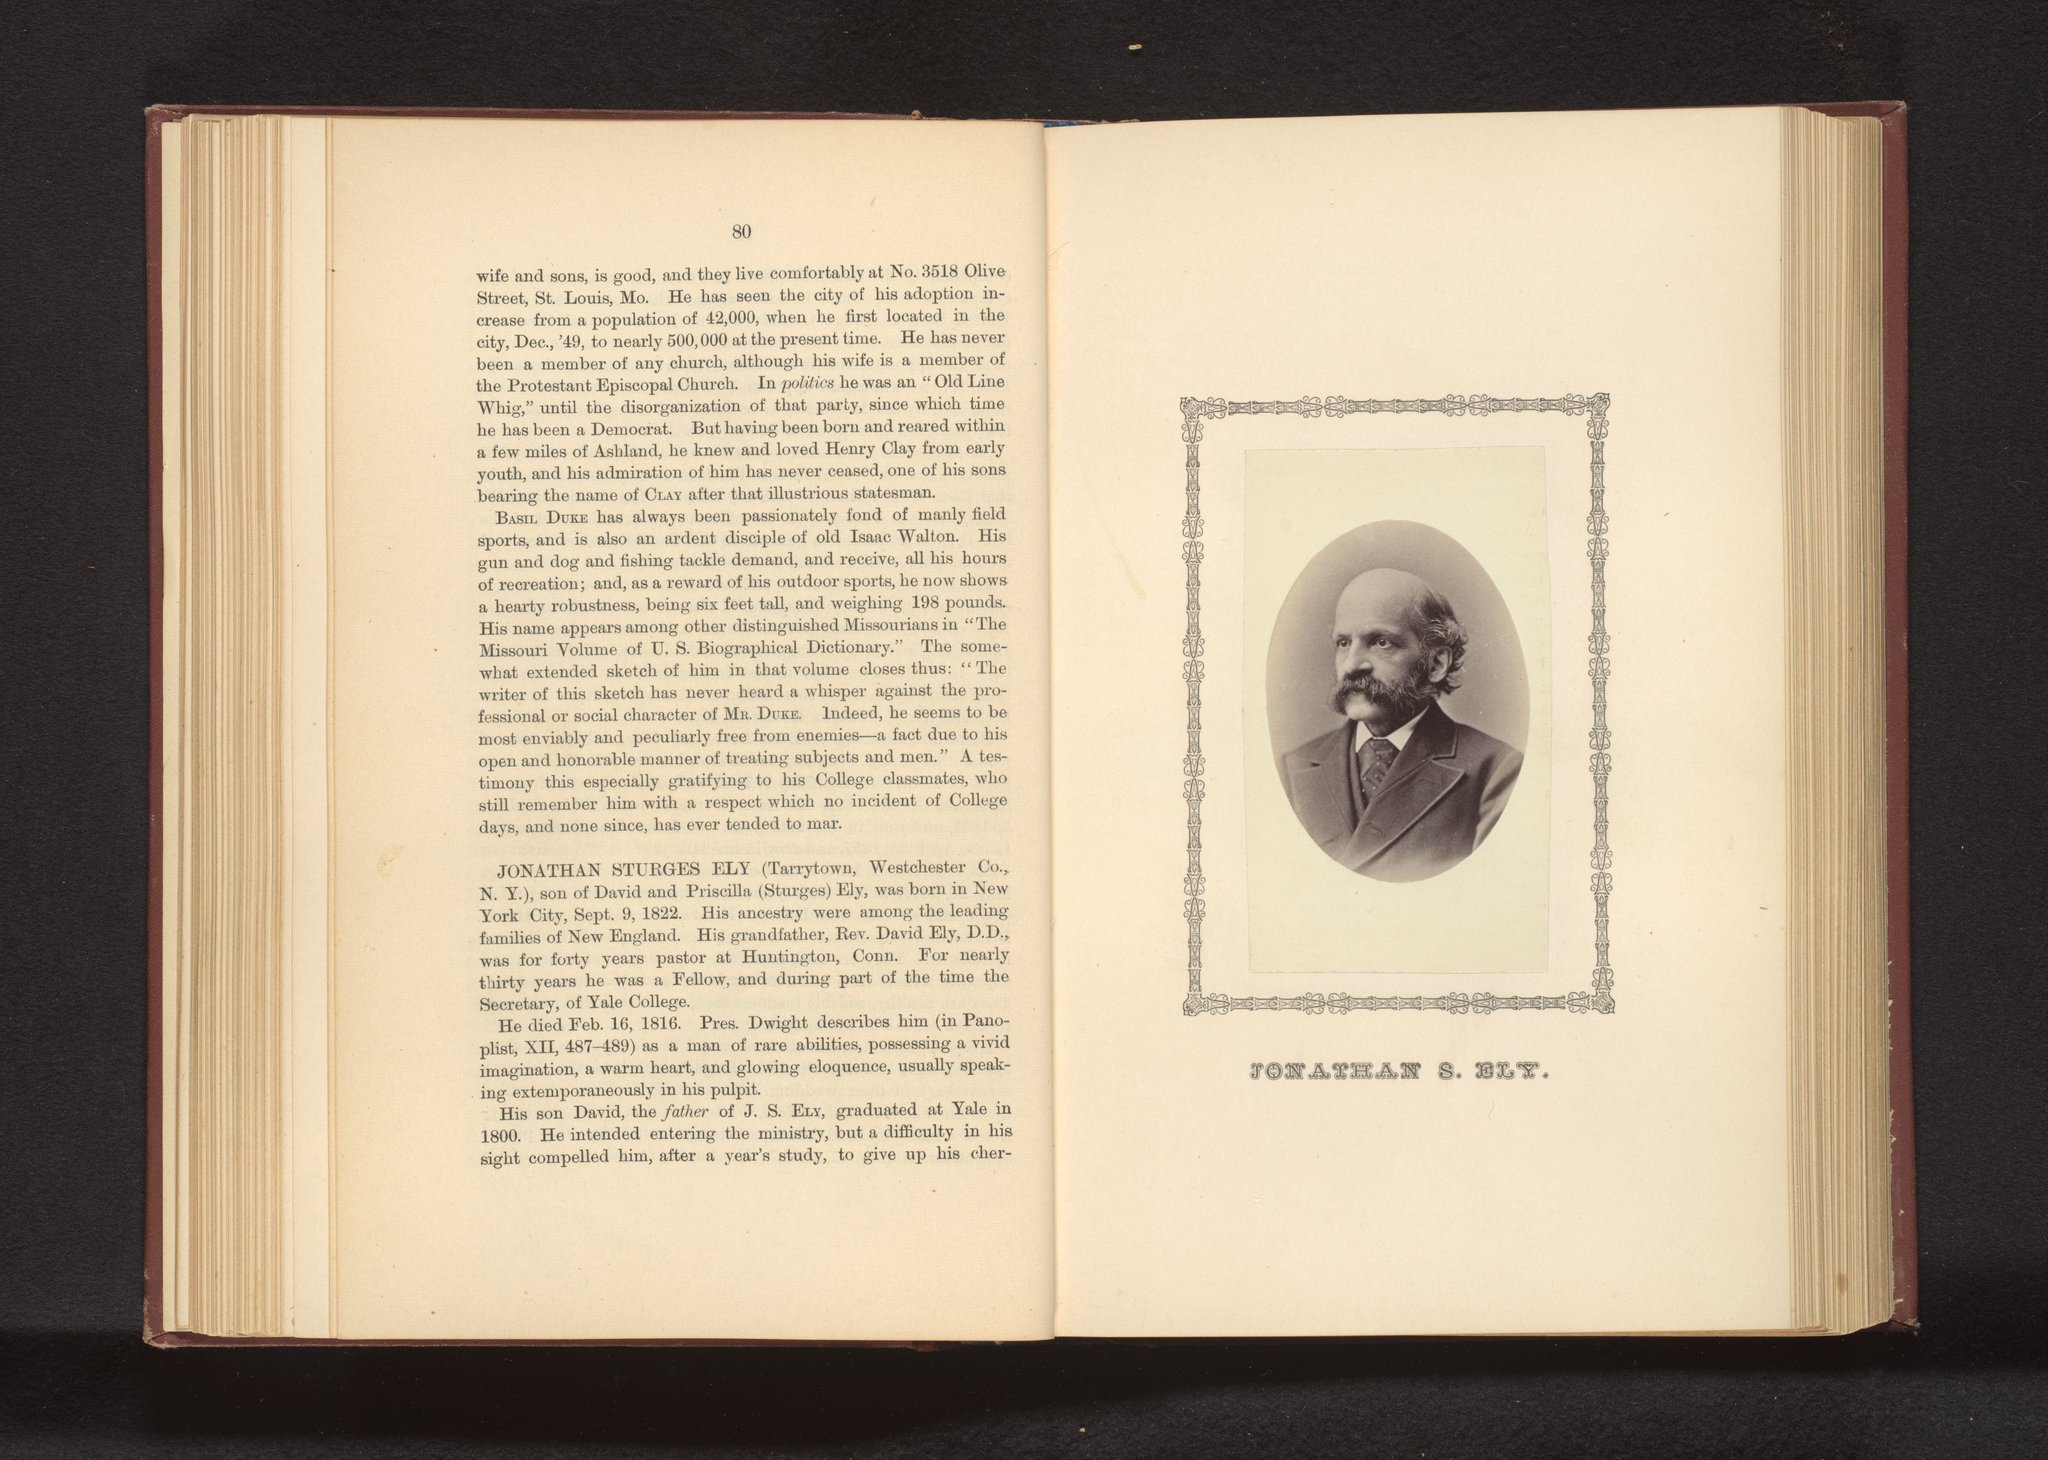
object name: page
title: Jonathan S. Ely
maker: Anonymous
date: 1876-1881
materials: photographic support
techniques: albumen print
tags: adult man